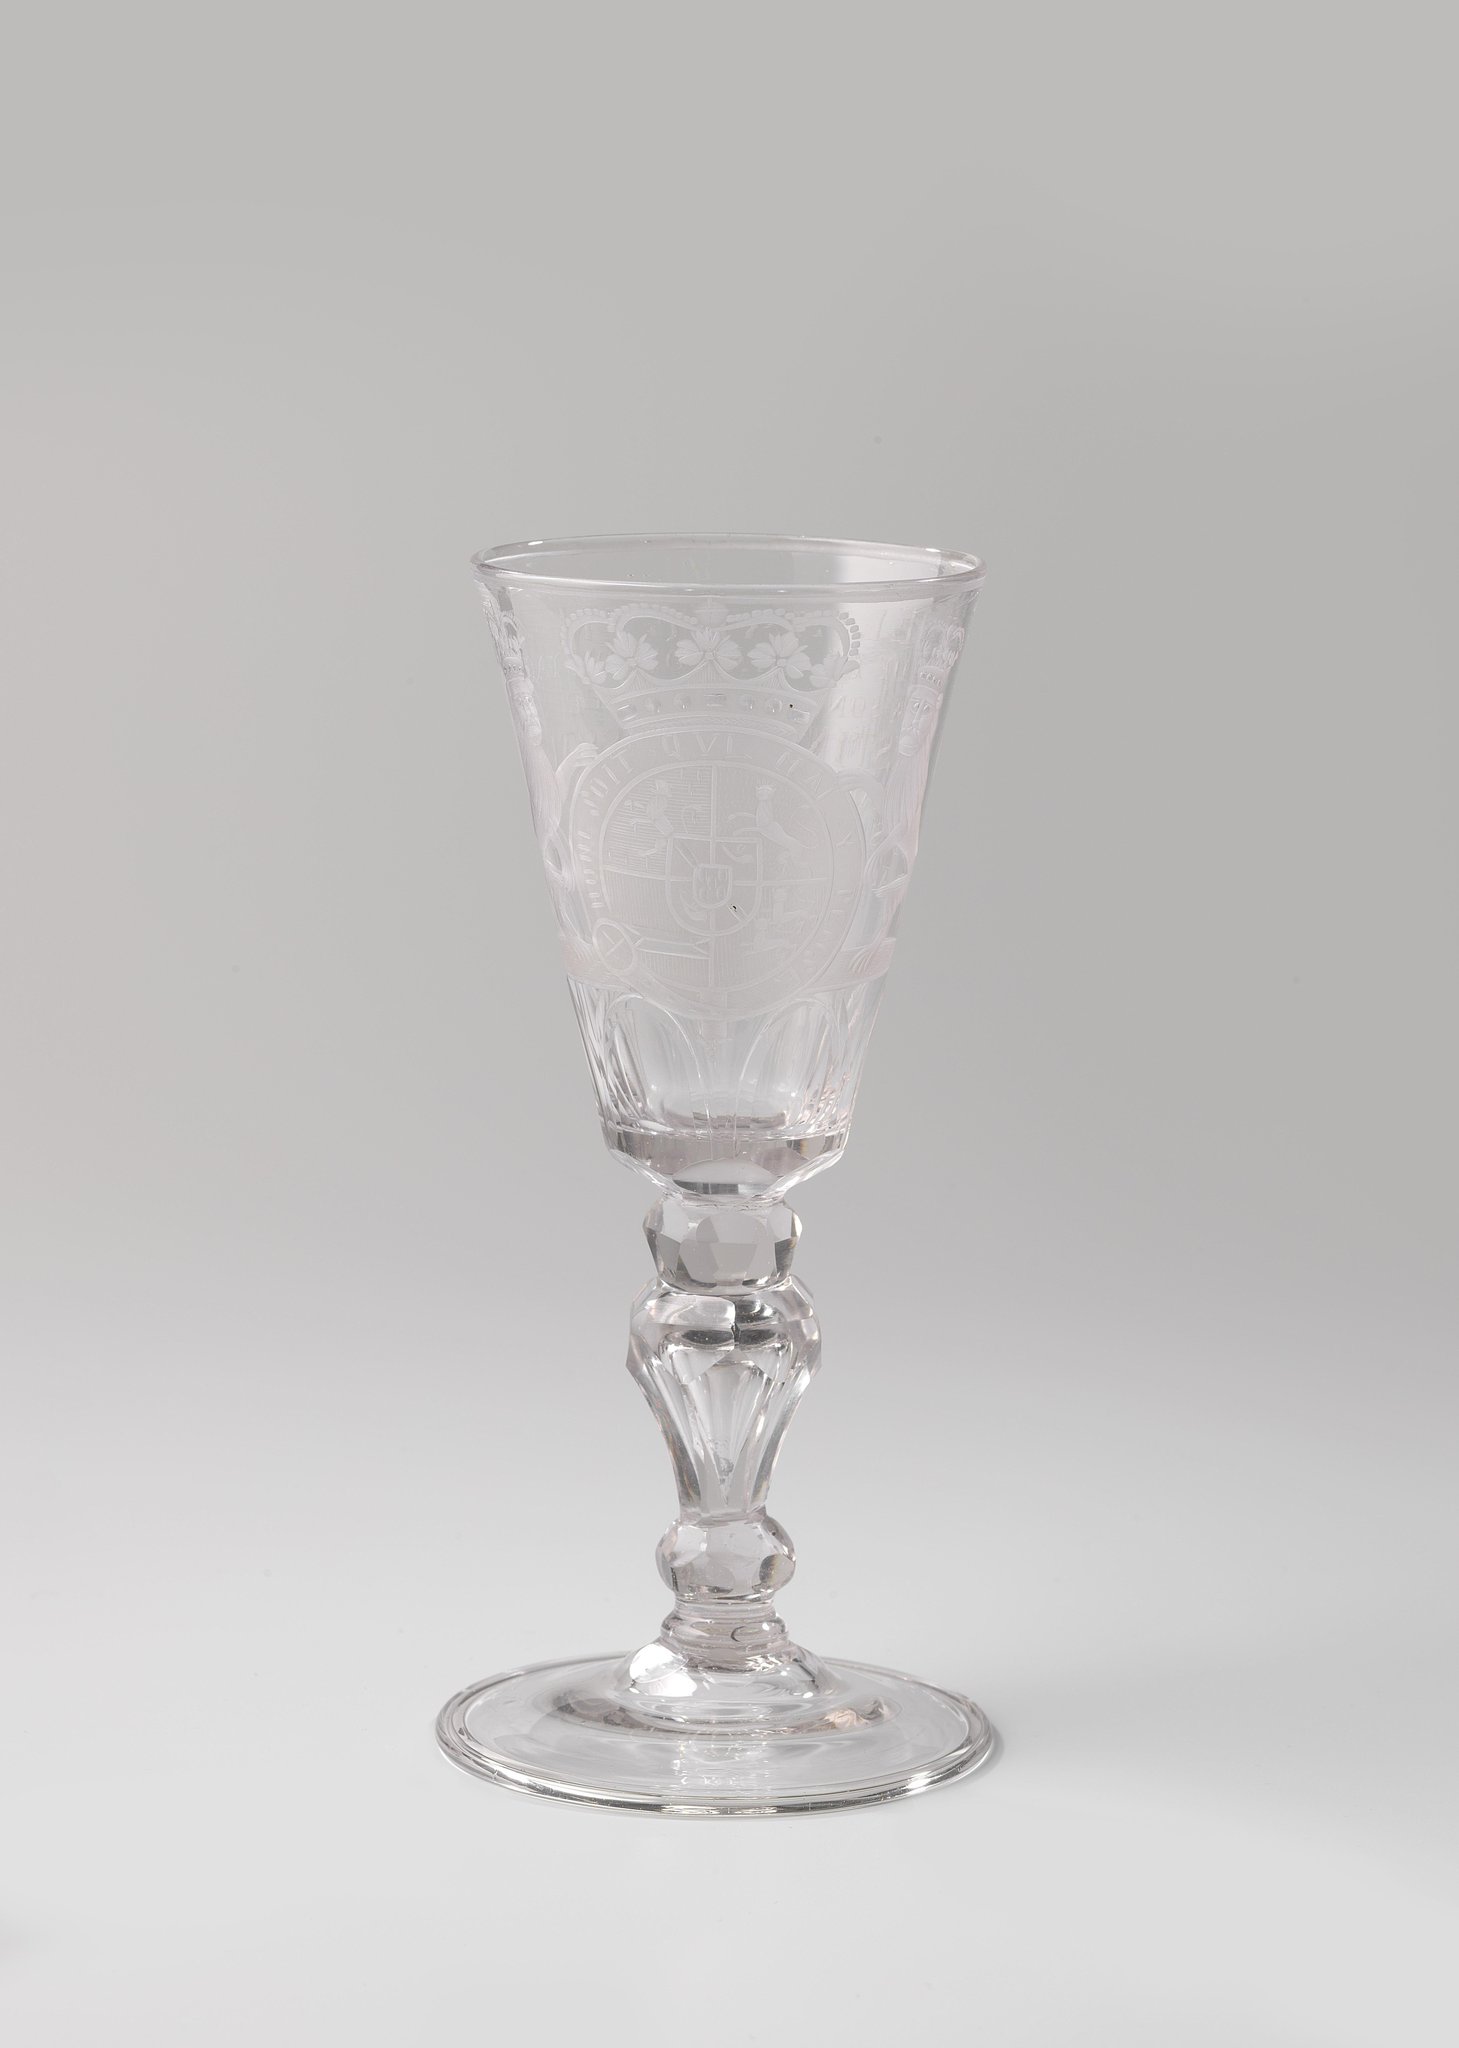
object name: goblet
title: Bokaal met het wapen van Willem IV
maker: Anonymous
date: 1733-1750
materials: glass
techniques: glassblowing, grinding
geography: bohemia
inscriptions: inscription: ‘HONI SOIT QUI MAL Y PENSE’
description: Bokaal van helder, kleurloos glas met het gekroonde wapen van stadhouder prins Willem IV en de Engelse kroon en inscriptie HONI SOIT QUI MAL Y PENSE